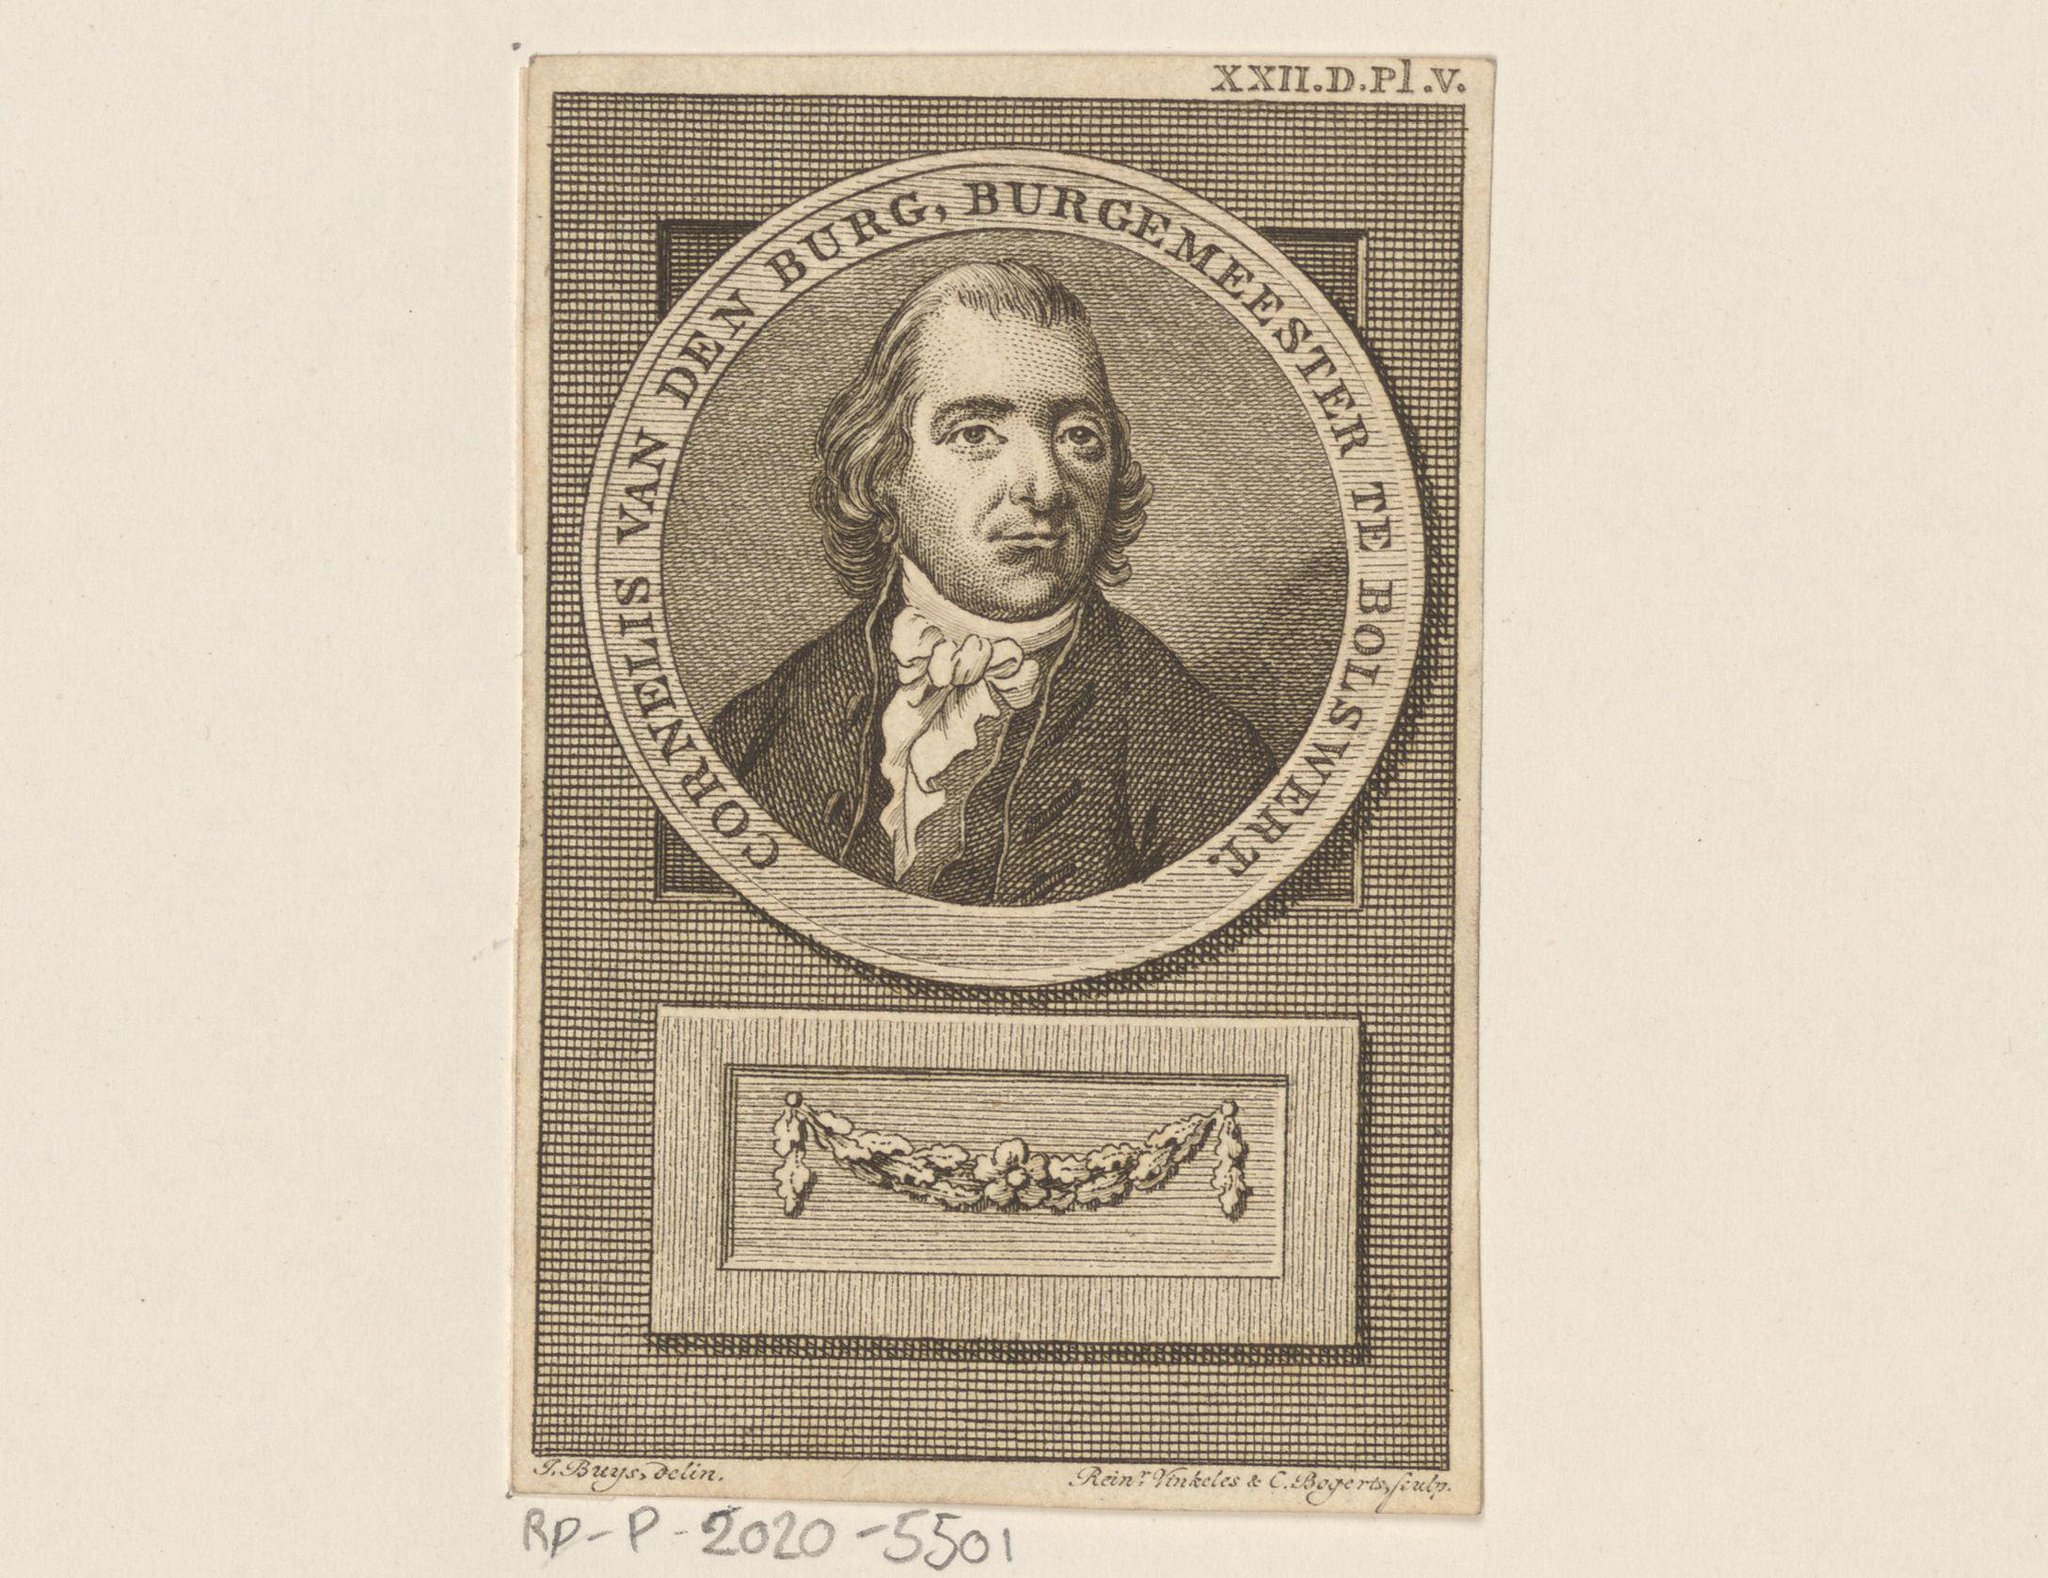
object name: print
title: Portret van Cornelis van der Burg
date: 1783-1795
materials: paper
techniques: engraving, etching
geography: amsterdam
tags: mayor, burgomaster, historical persons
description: Prent uit: Fokke, Jan. Geschiedenissen der Vereenigde Nederlanden voor de vaderlandsche jeugd (...). Amsterdam: Johannes Allart, 1783-1795, dl. 22.